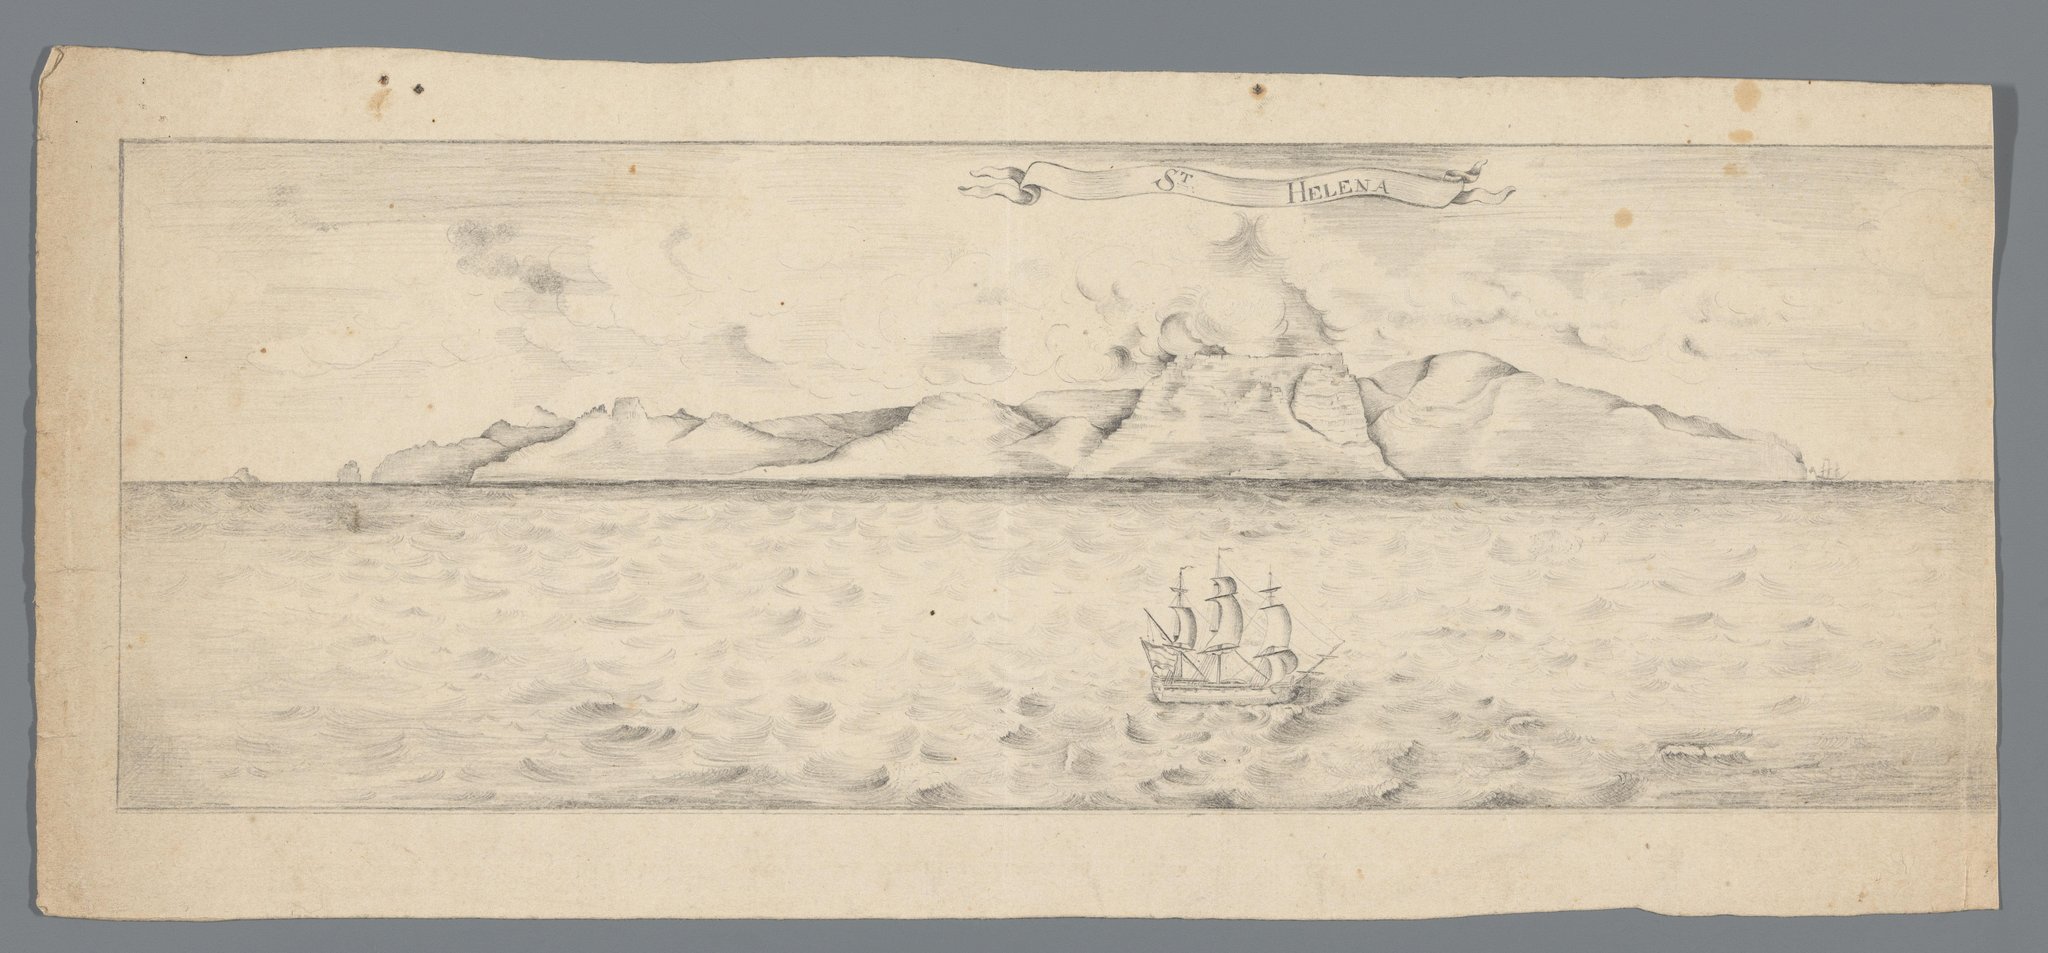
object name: drawing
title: Gezicht op Sint-Helena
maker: helena swellengrebel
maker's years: -1753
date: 1751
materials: paper, pencil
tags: island, sailing-ship, sailing-boat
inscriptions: label: ‘A1’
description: Gezicht op het eiland Sint-Helena, waarschijnlijk gemaakt op de reis van de Kaapkolonie naar Nederland door een van de dames Swellengrebel.